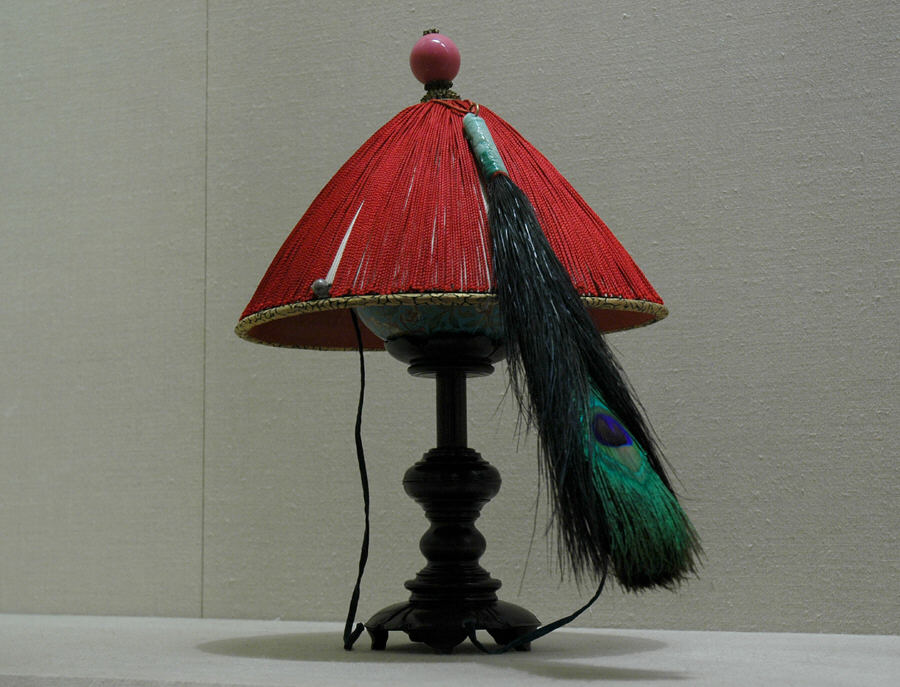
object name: man's summer court hat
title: Man's Summer Court Hat with Peacock Feather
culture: chinese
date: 1644-1911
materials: glass, silk